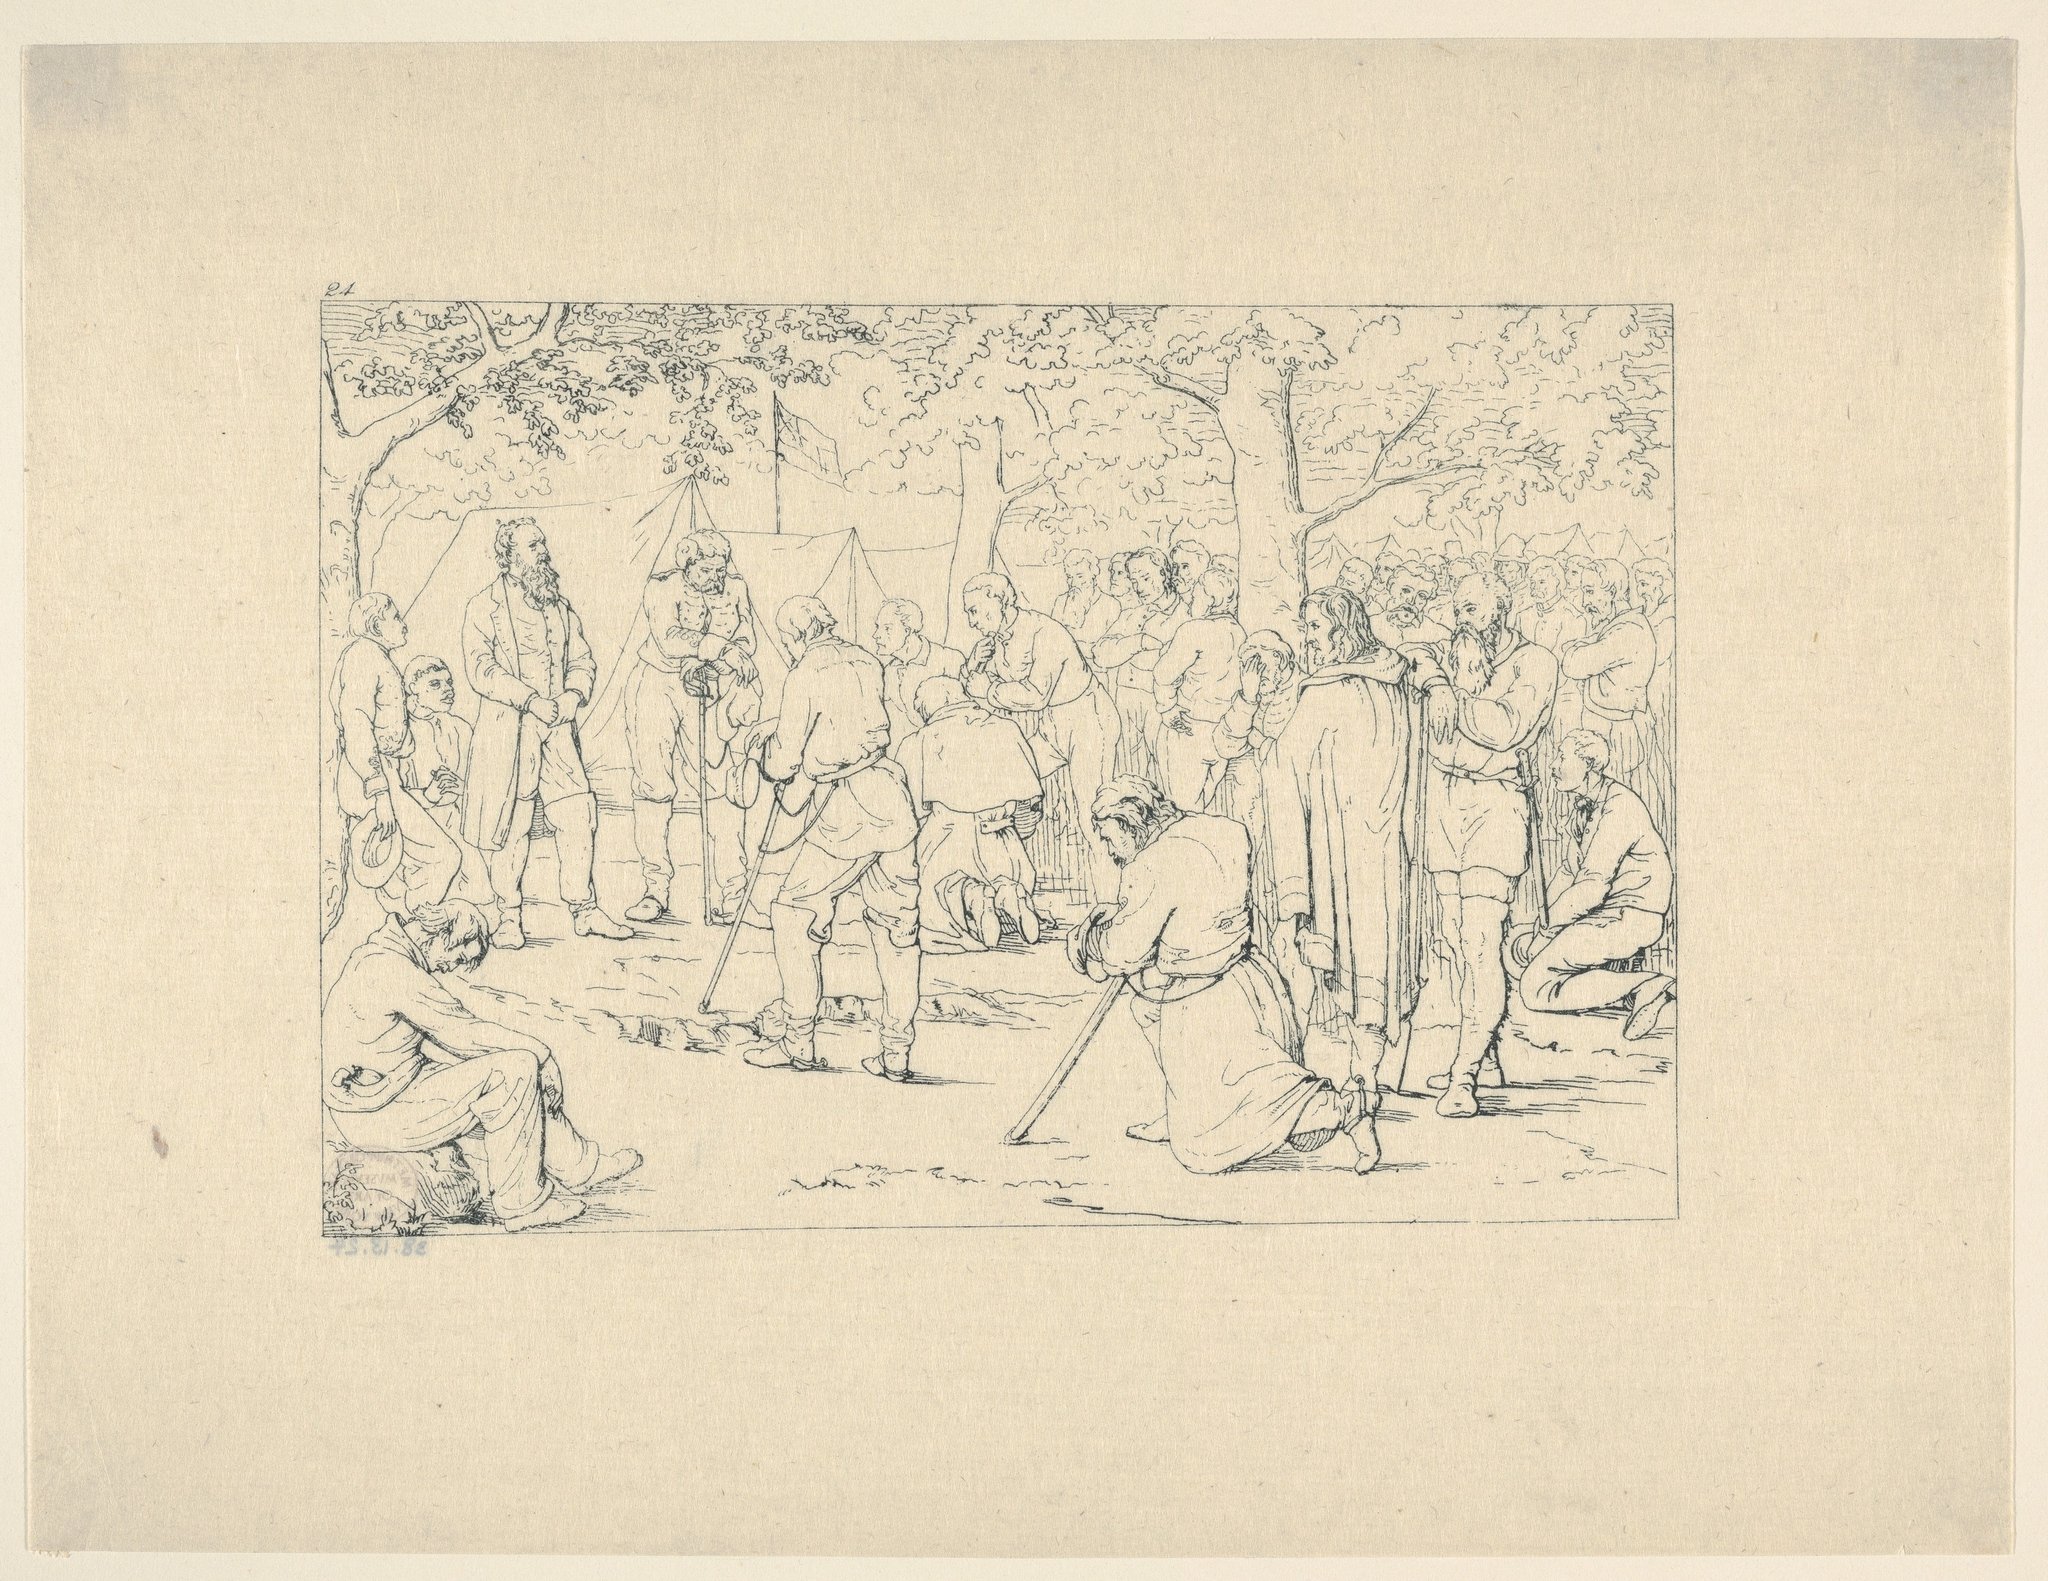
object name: print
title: Prayer in Stonewall Jackson's Camp (from Confederate War Etchings)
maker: adalbert john volck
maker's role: artist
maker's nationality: american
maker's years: 1828-1912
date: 1861-1863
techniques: etching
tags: soldiers,american civil war,men